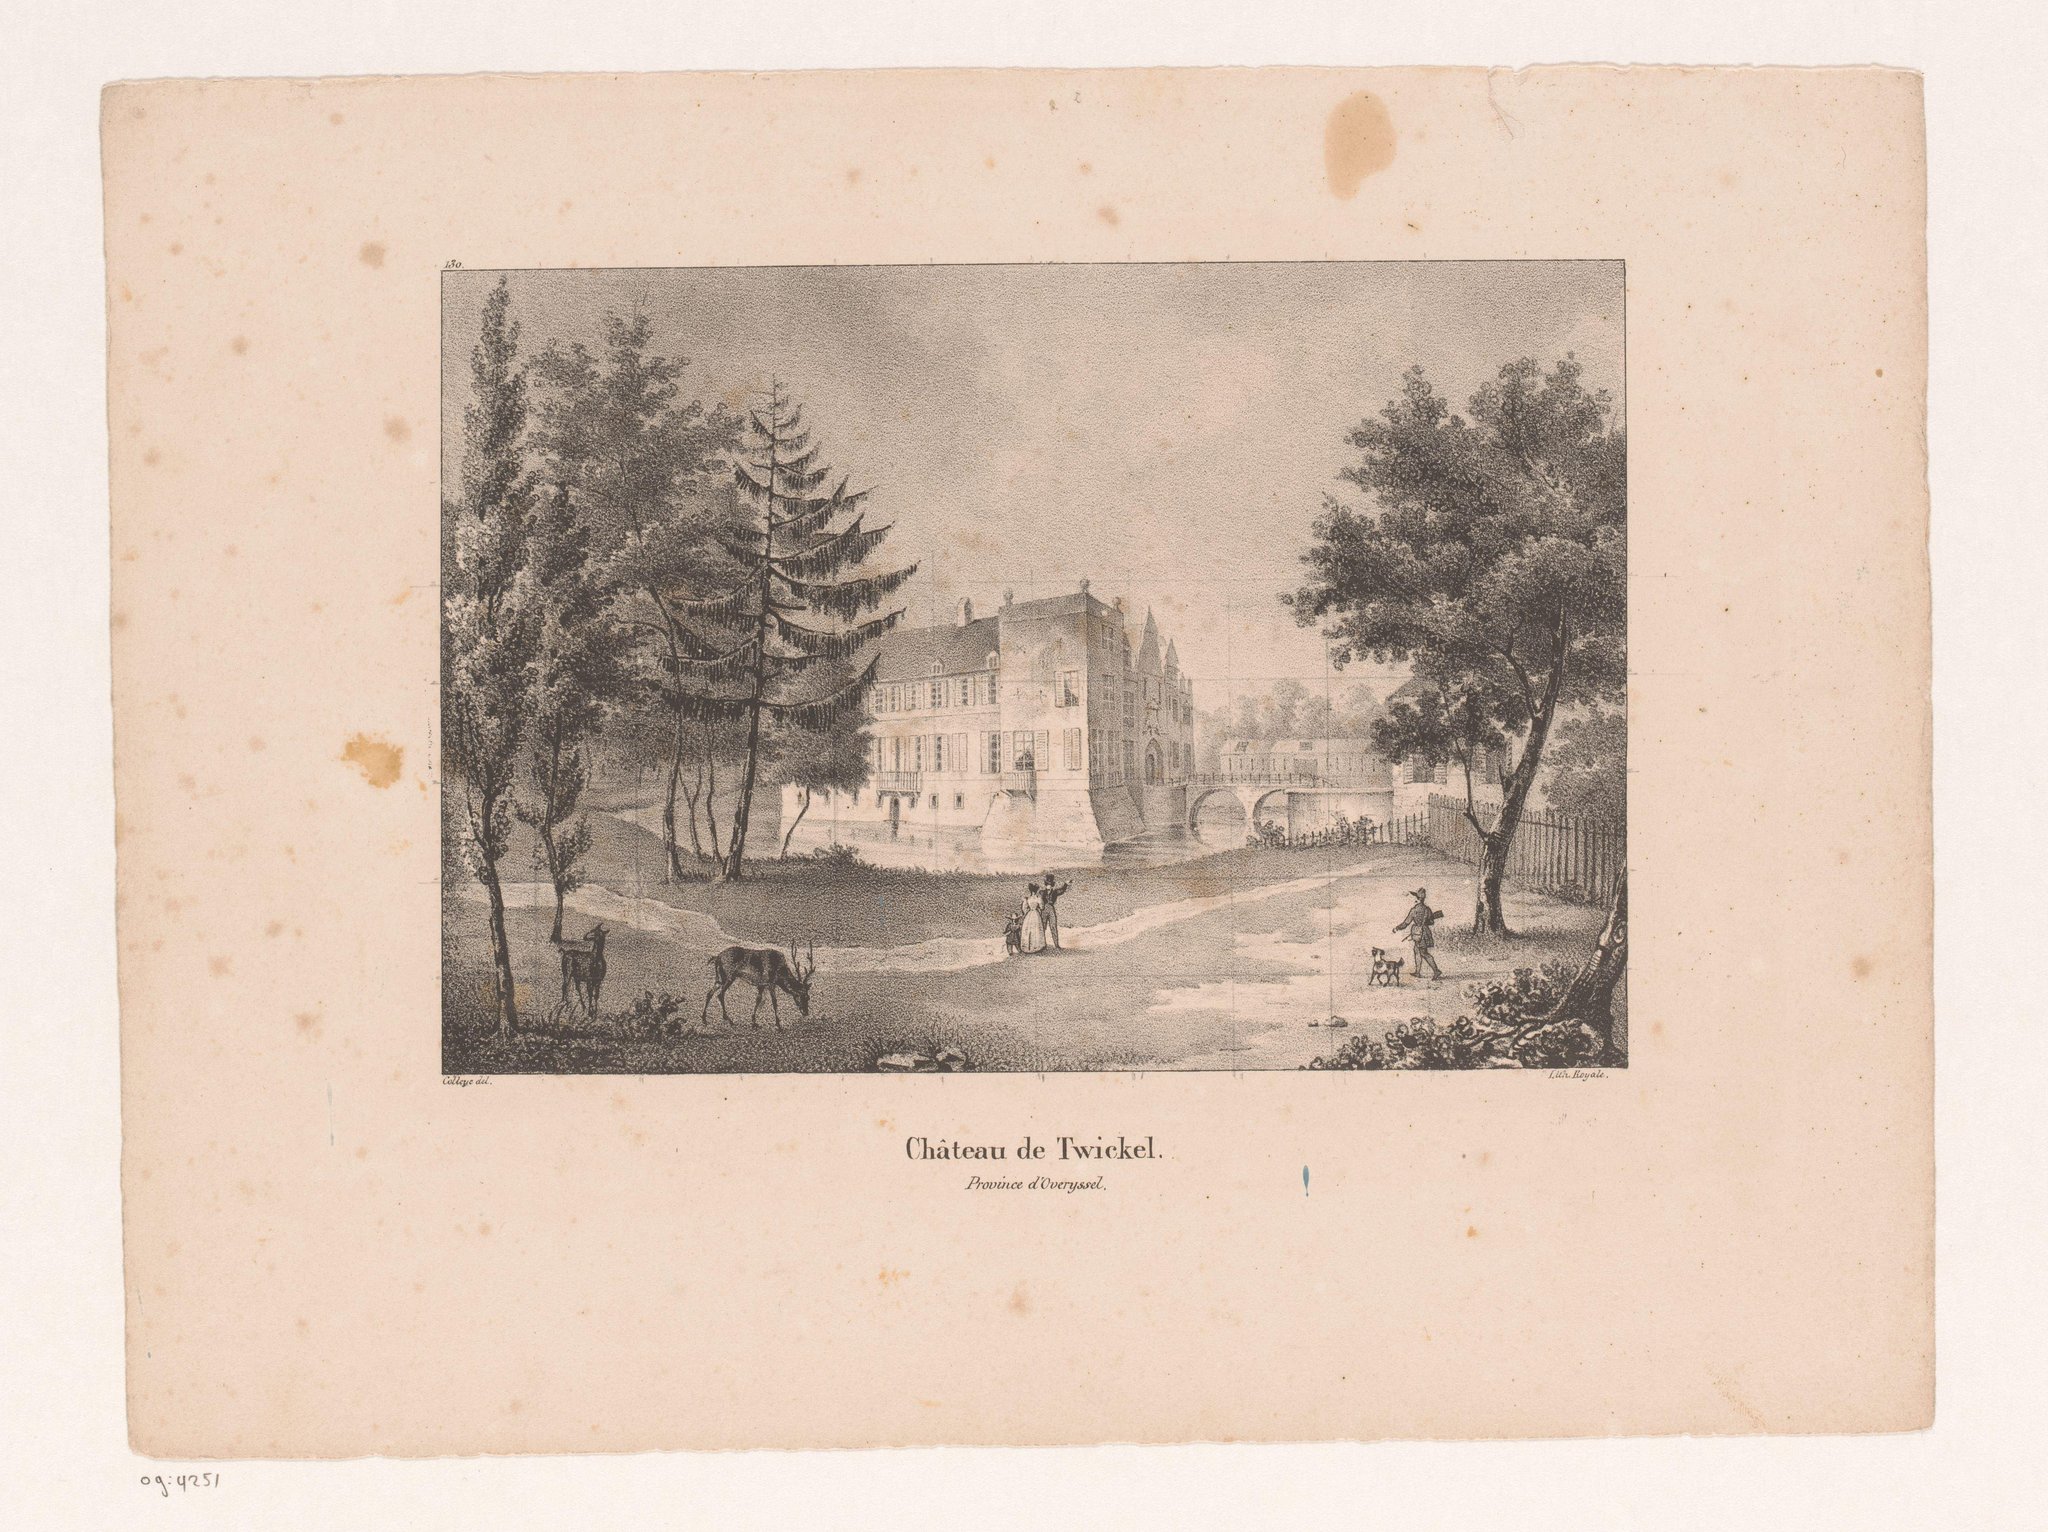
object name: print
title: Gezicht op kasteel Twickel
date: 1825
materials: paper, pencil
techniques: lithograph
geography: brussels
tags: hoofed animals: deer, castle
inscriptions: collector's mark: Lugt 2228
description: Over een gedeelte van de prent is met potlood een rasterverdeling aangebracht.